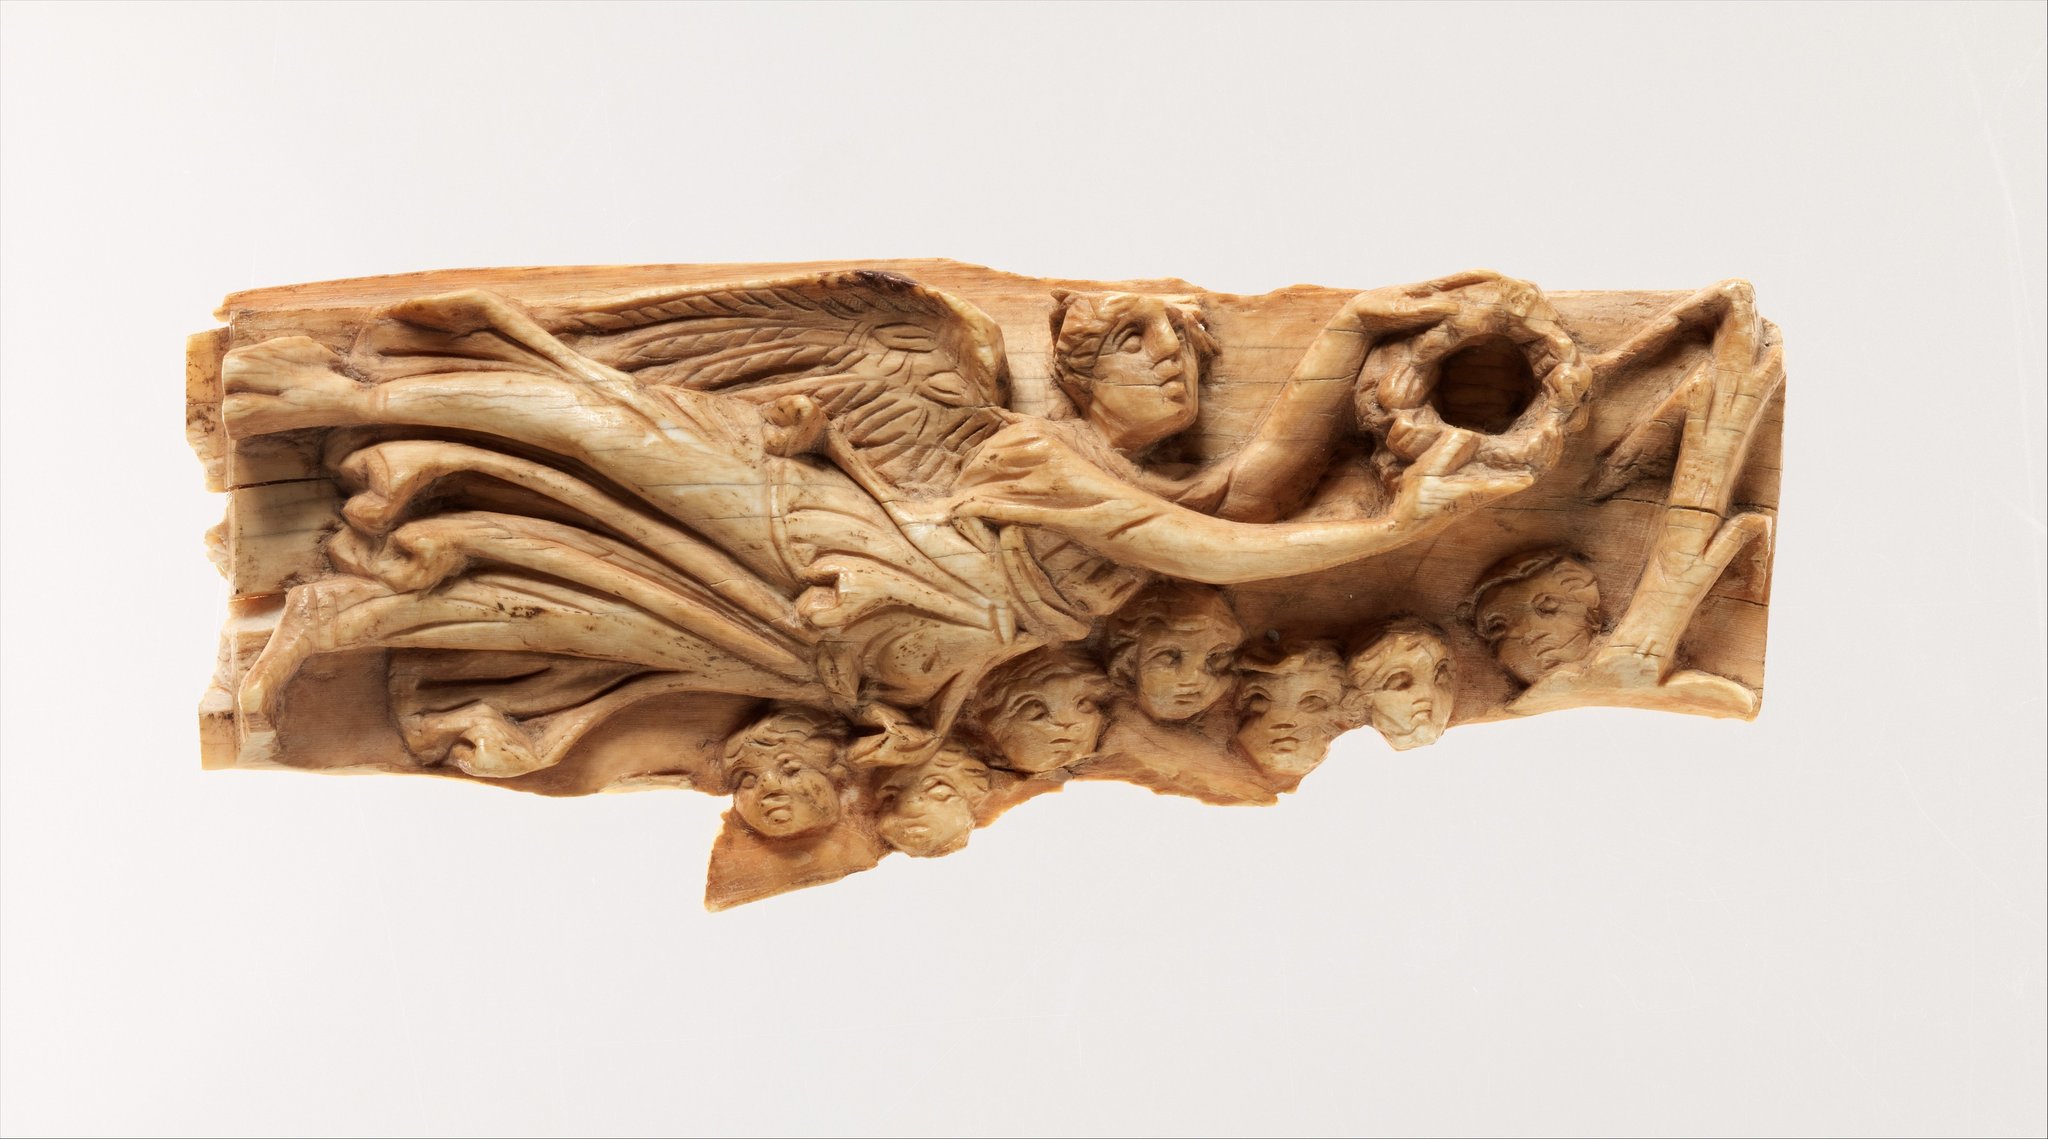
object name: plaque fragment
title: Fragment with Personifications of Victory and the Nile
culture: byzantine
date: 501-600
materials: ivory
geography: egypt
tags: heads,nike,wreaths